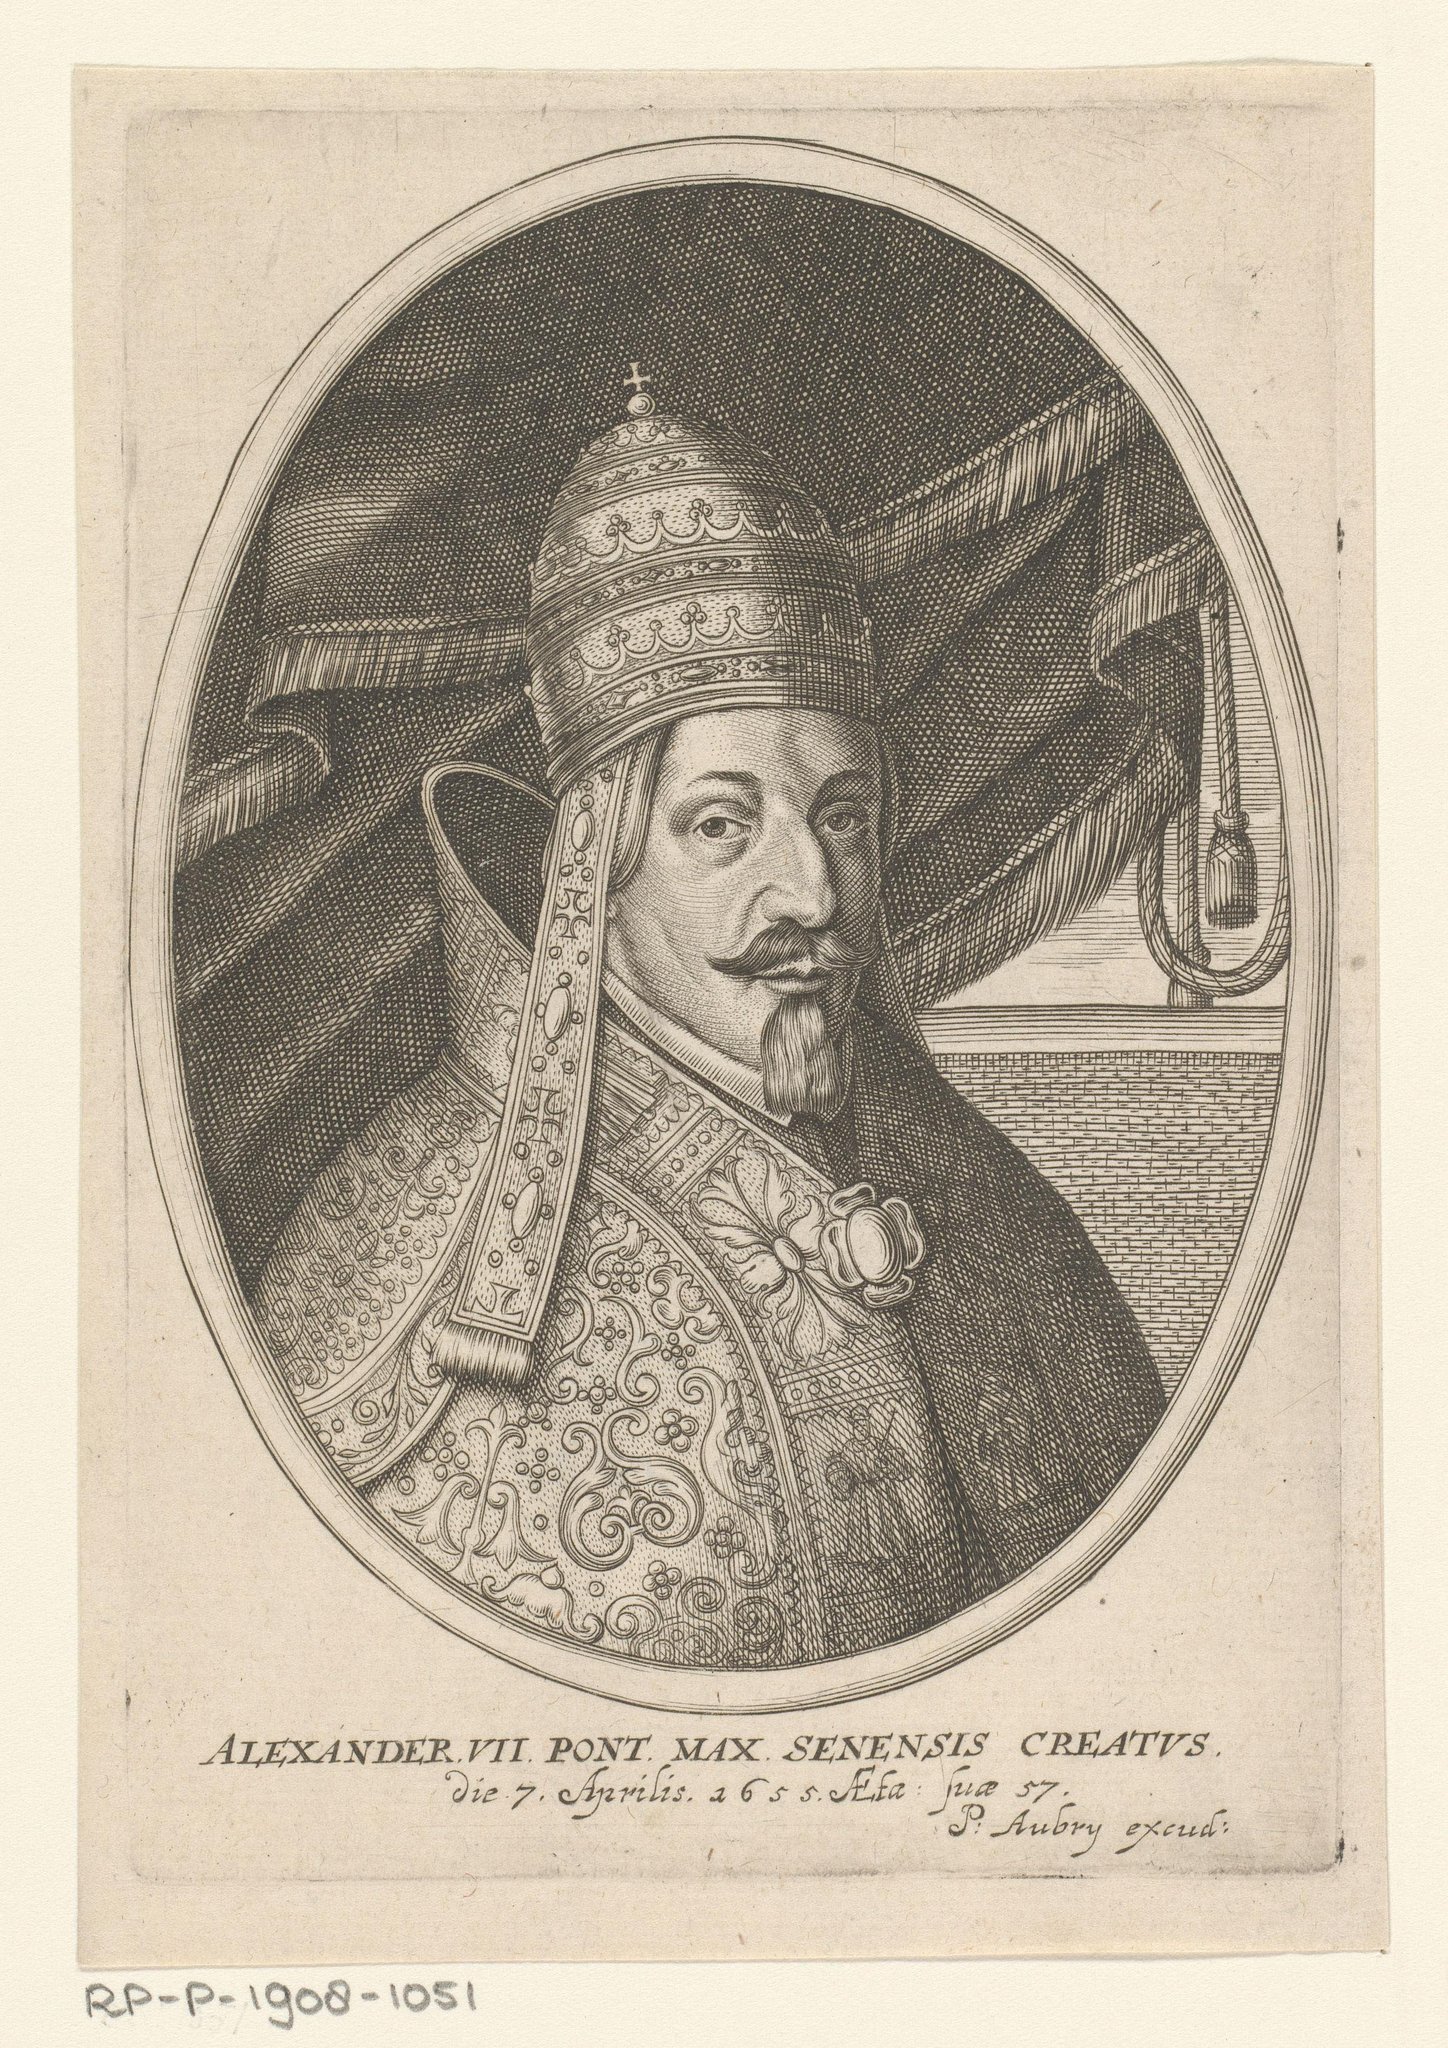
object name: print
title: Portret van Alexander VII op 57-jarige leeftijd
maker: Anonymous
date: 1655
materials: paper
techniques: engraving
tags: rome, alexander vii, historical persons, pope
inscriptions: collector's mark: Lugt 2228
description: Met tweeregelig onderschrift in het Latijn.